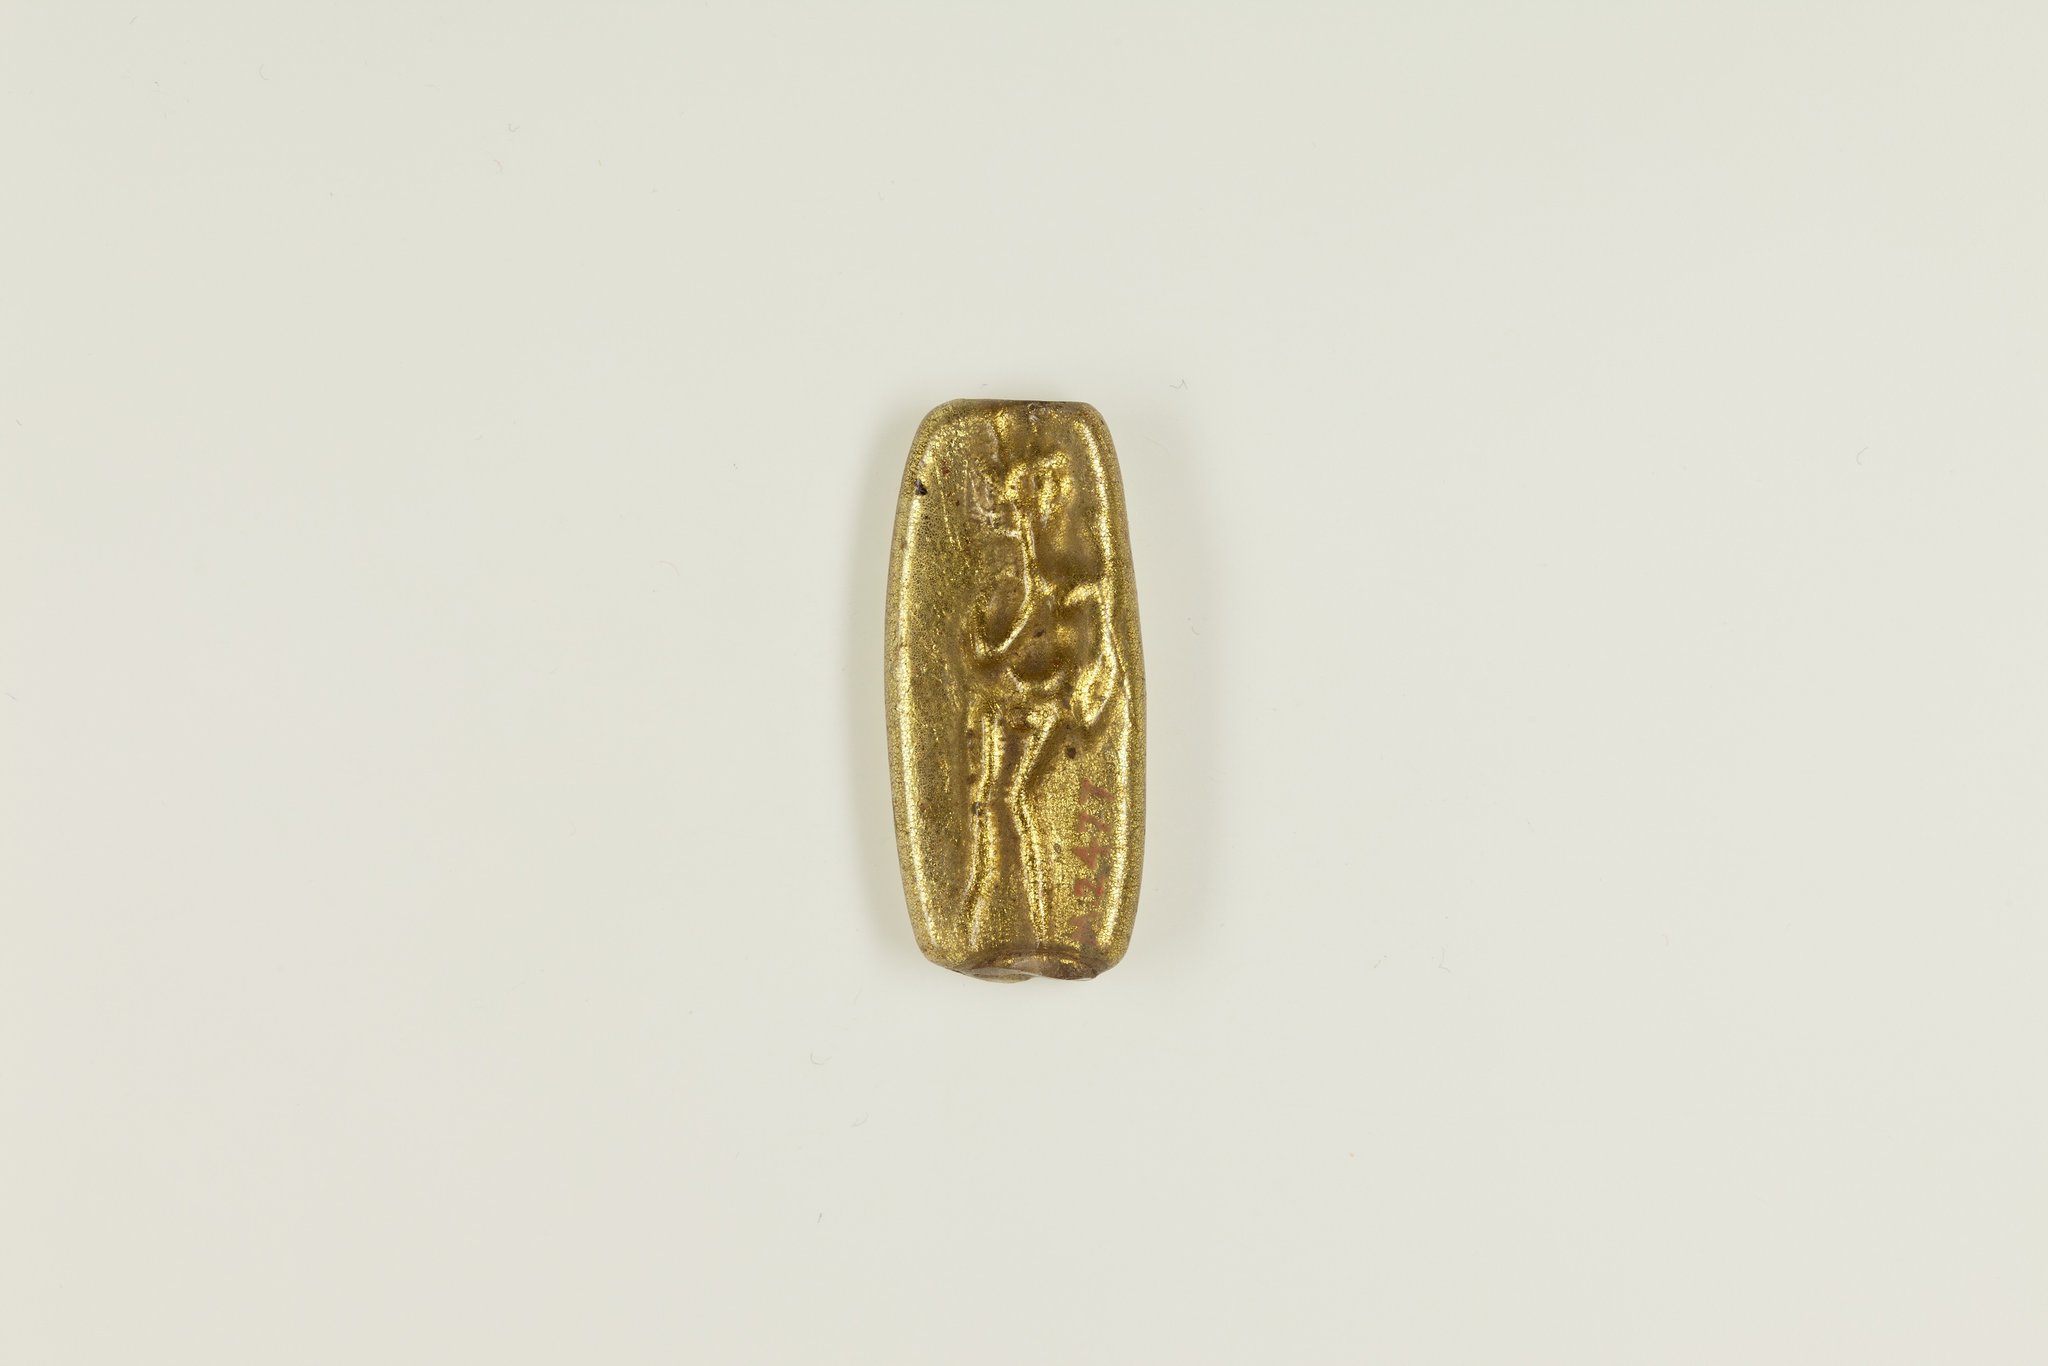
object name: necklace, bead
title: Bead with figure of Harpokrates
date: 100 BCE-100 CE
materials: glass, gold foil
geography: egypt